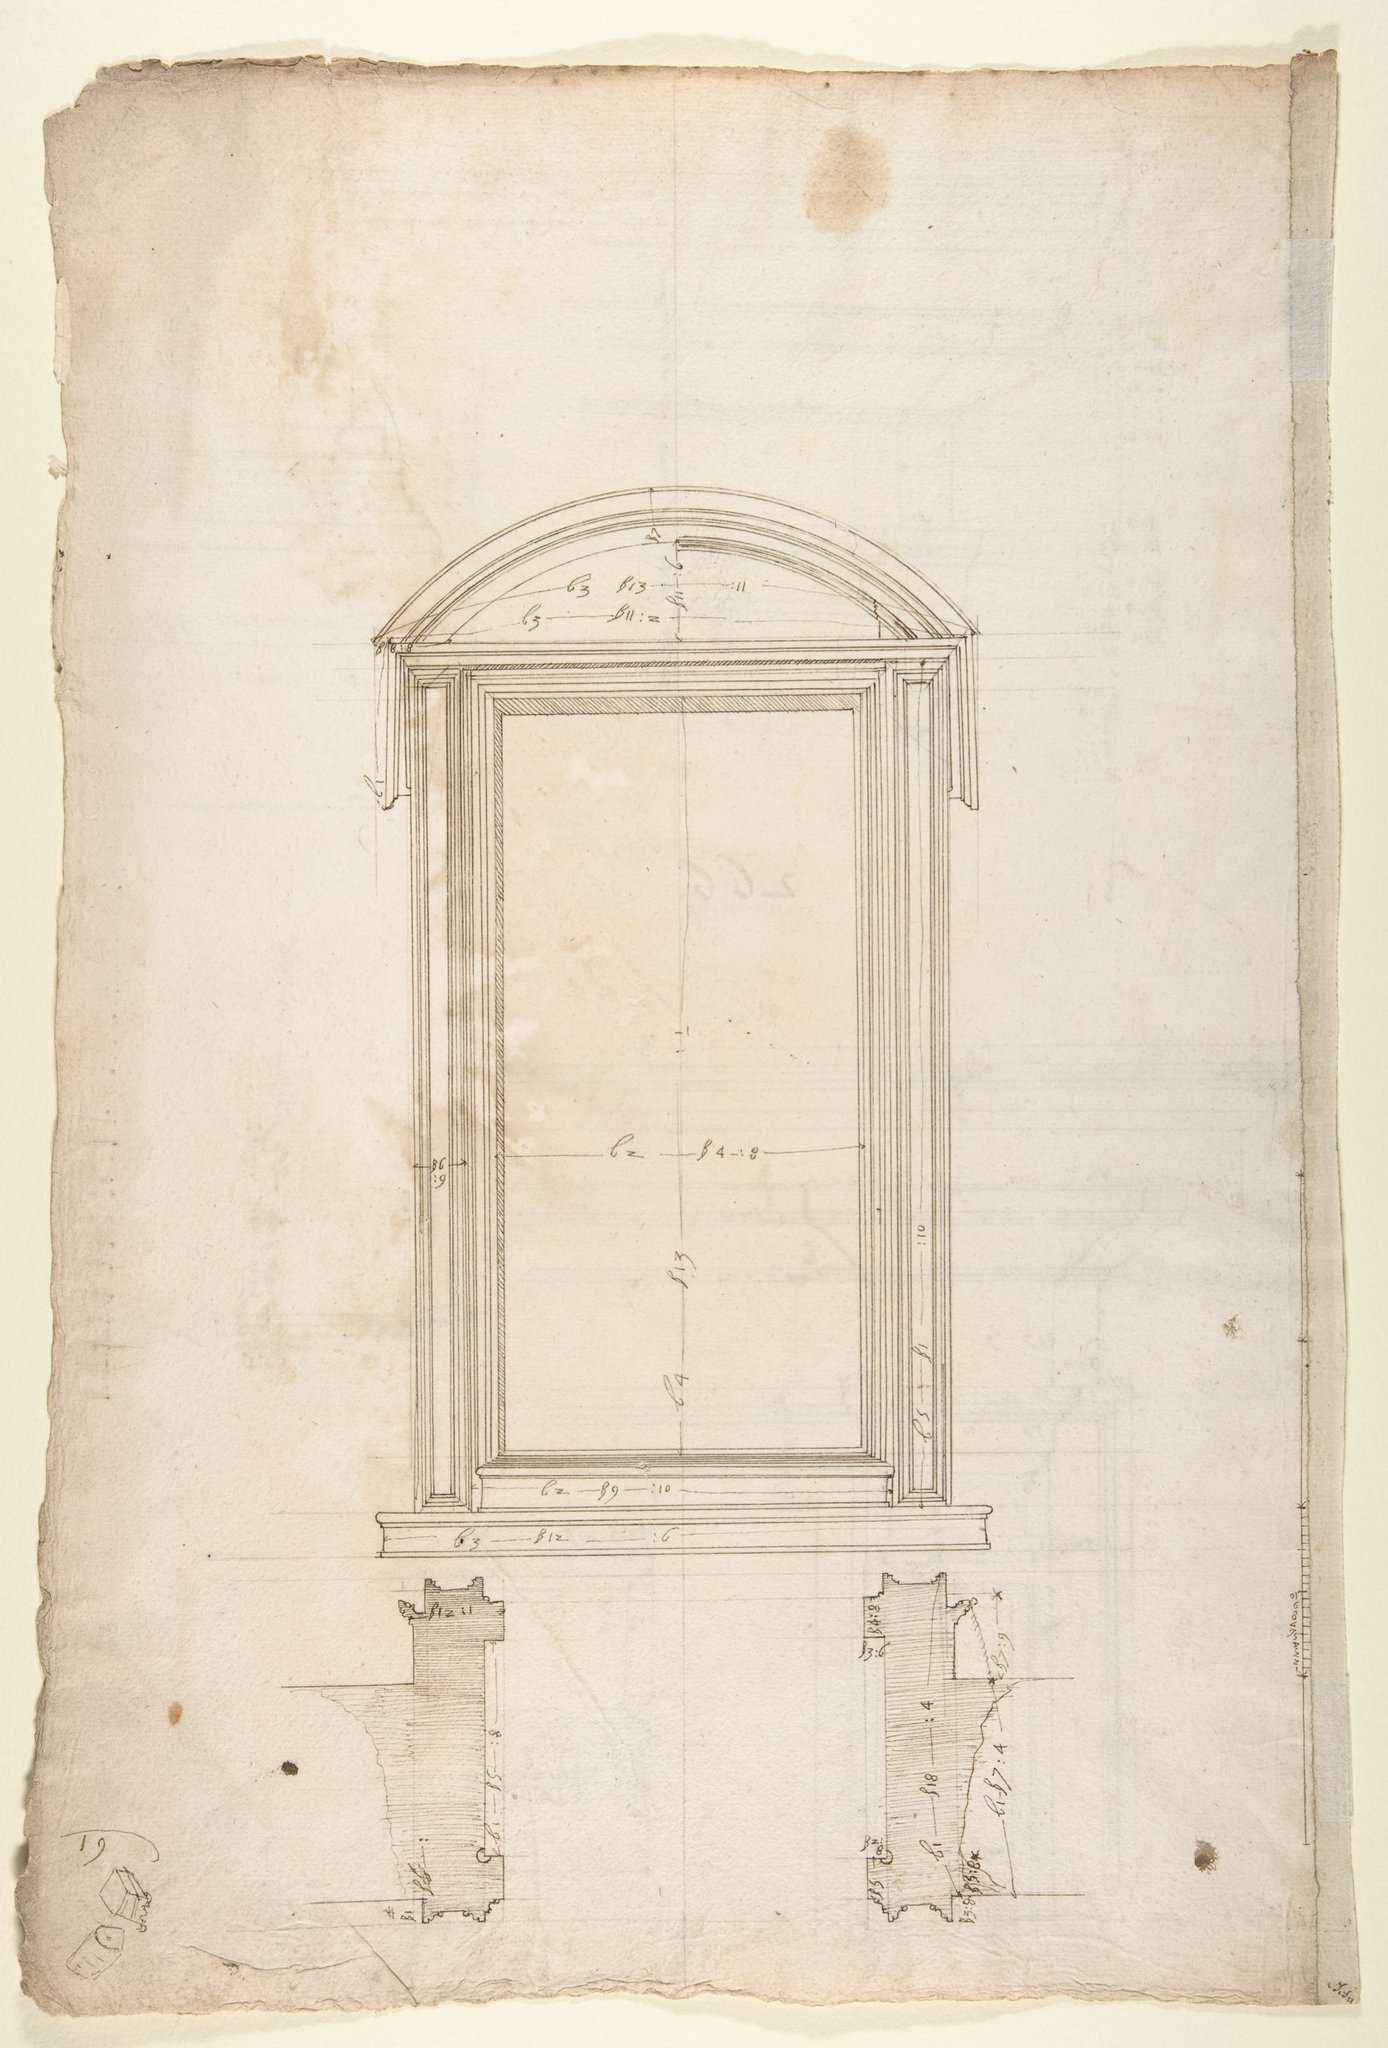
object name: drawing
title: San Lorenzo, Library, Ricetto, portal to Ricetto, elevation; plan (recto) San Lorenzo, Library, Ricetto, portal from cloister, details (verso)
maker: anonymous, french, 16th century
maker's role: draftsman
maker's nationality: french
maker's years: 1500-1600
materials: chalk, ink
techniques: incising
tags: architecture